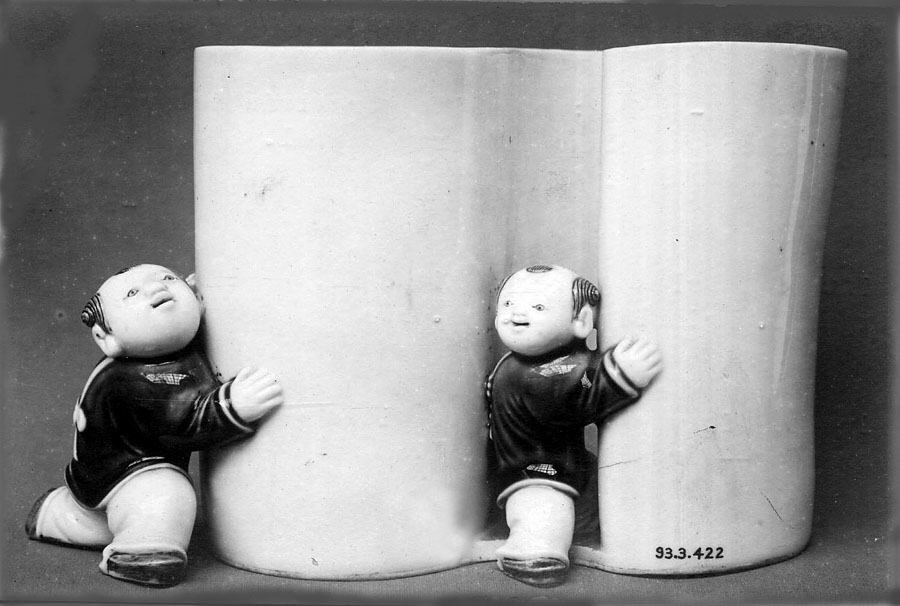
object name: brush holder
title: Brush-holder with Figures of Chinese Children Unrolling a Scroll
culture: japanese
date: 1780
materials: enamel, glaze, porcelain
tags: scrolls,children